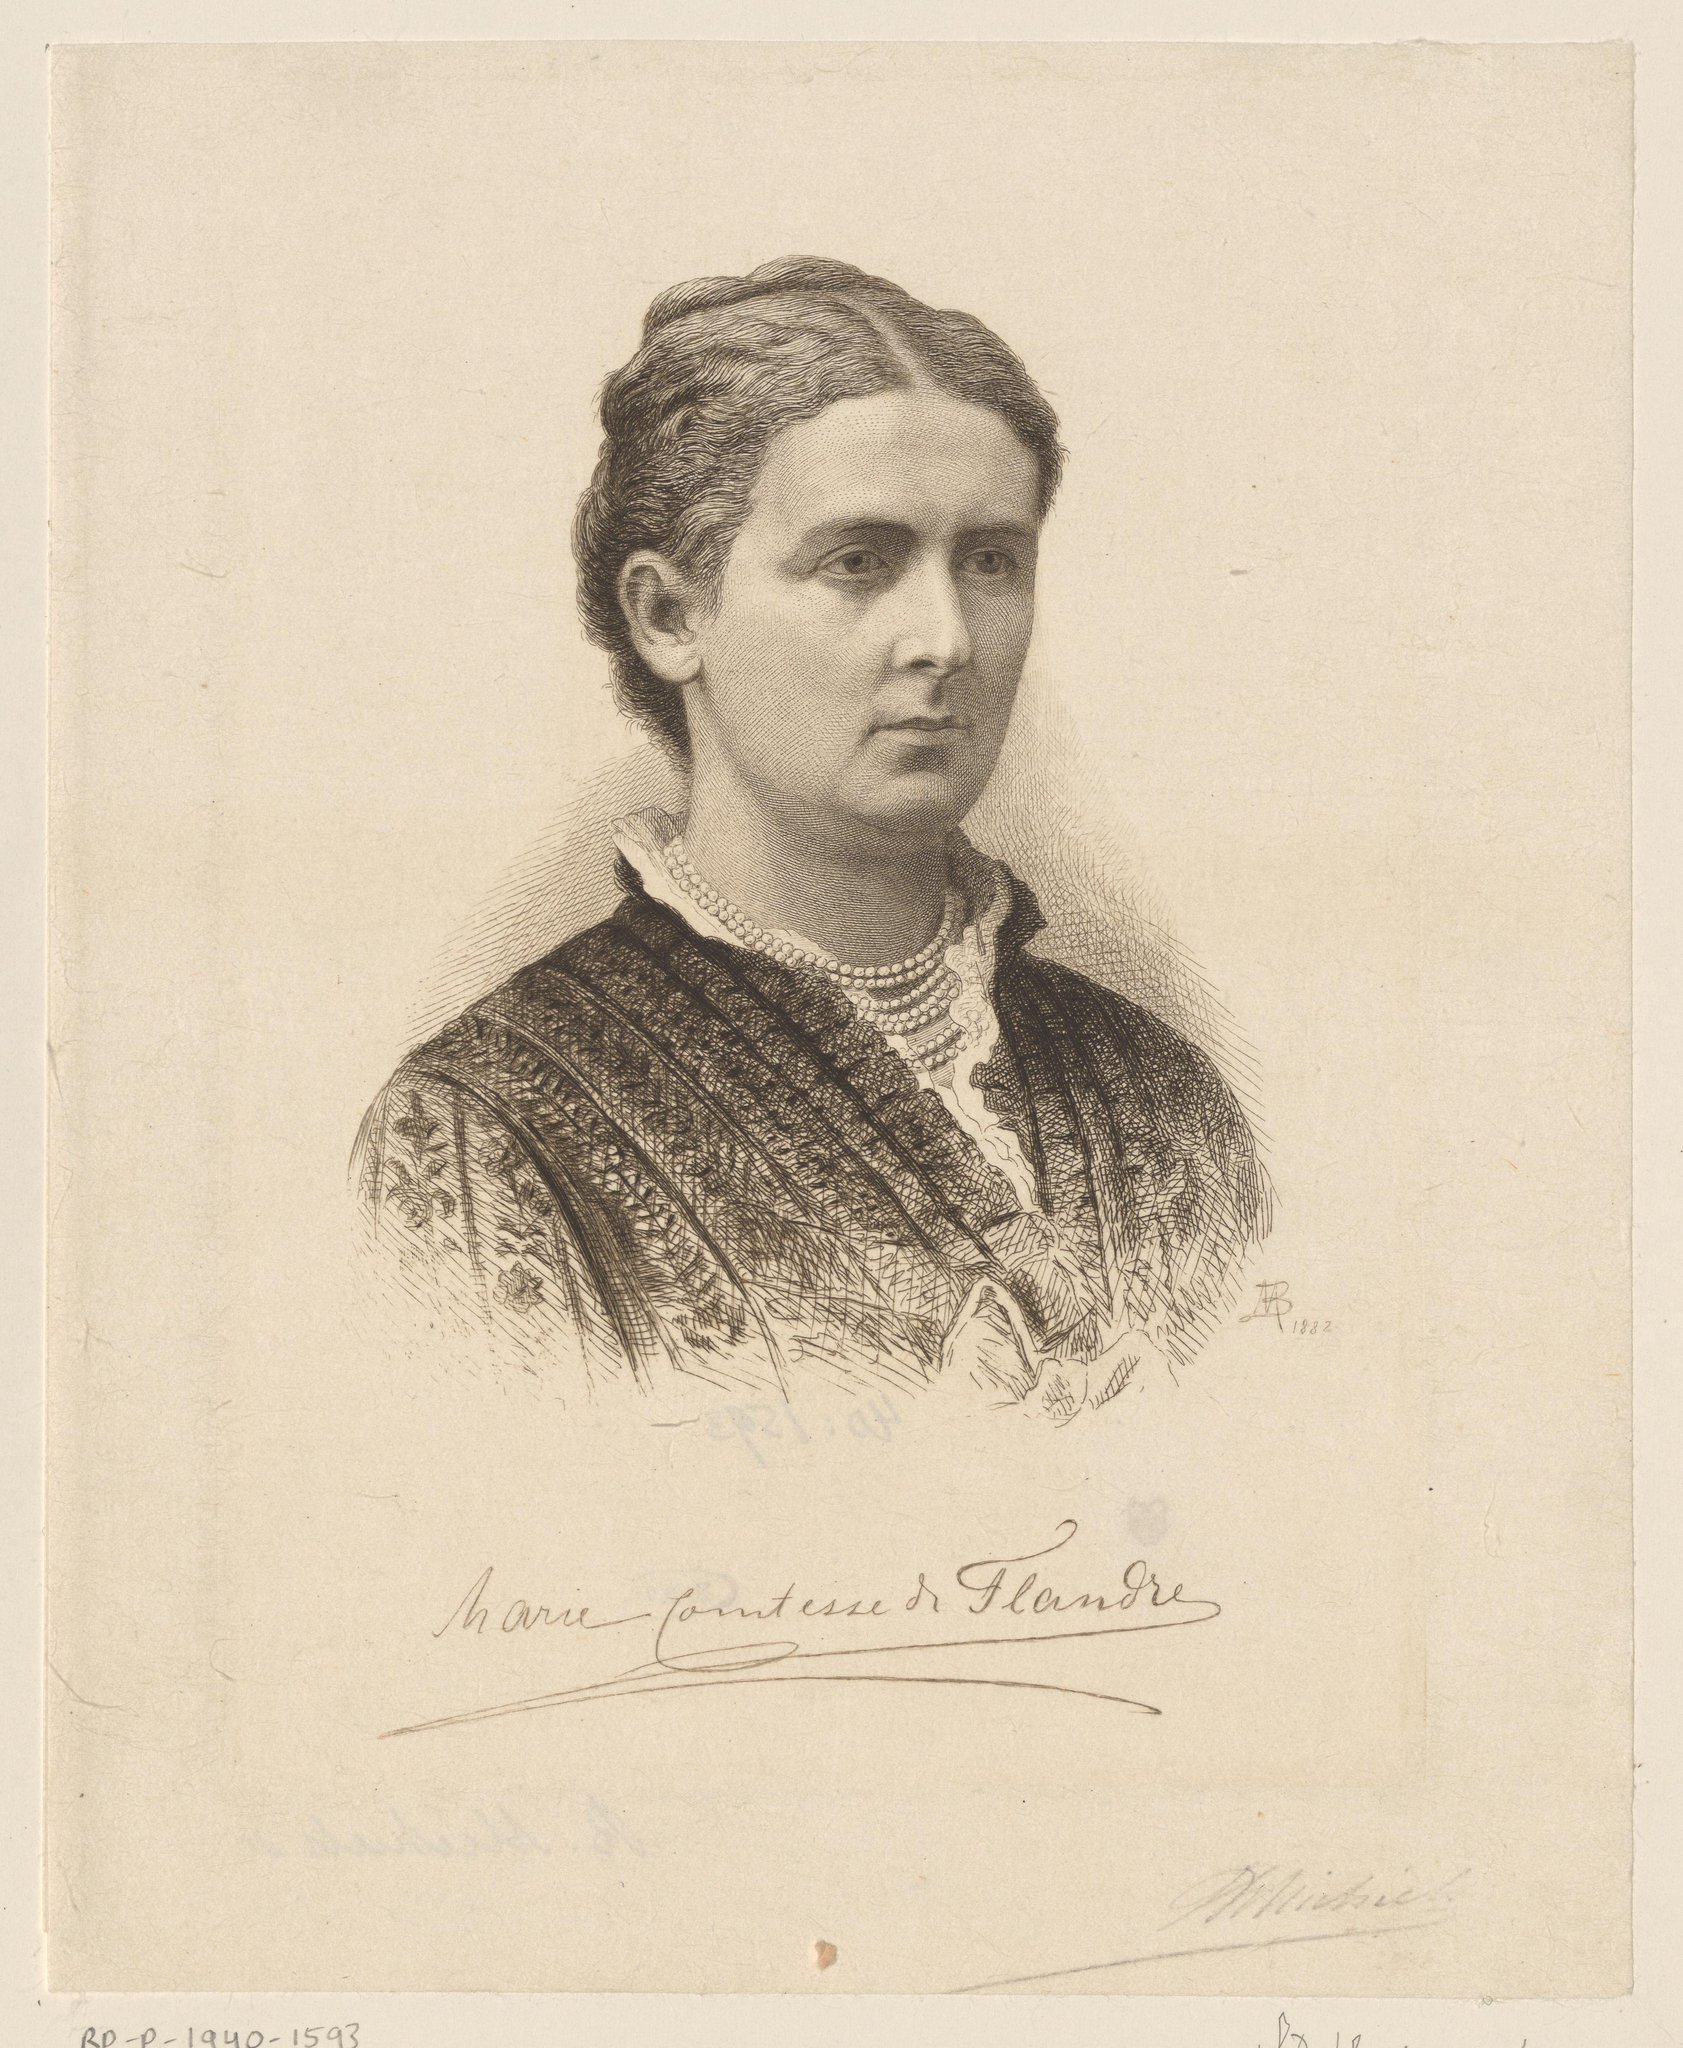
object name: print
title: Portret van Maria van Hohenzollern-Sigmaringen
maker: jean baptiste pierre michiels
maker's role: print maker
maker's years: 1821-1890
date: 1882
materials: paper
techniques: etching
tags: brussels, print maker, maria van hohenzollern-sigmaringen (gravin van vlaanderen), historical persons - bb - woman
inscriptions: collector's mark: Lugt 2228, signature: ‘BMichiels’, collector's mark: Lugt 2760